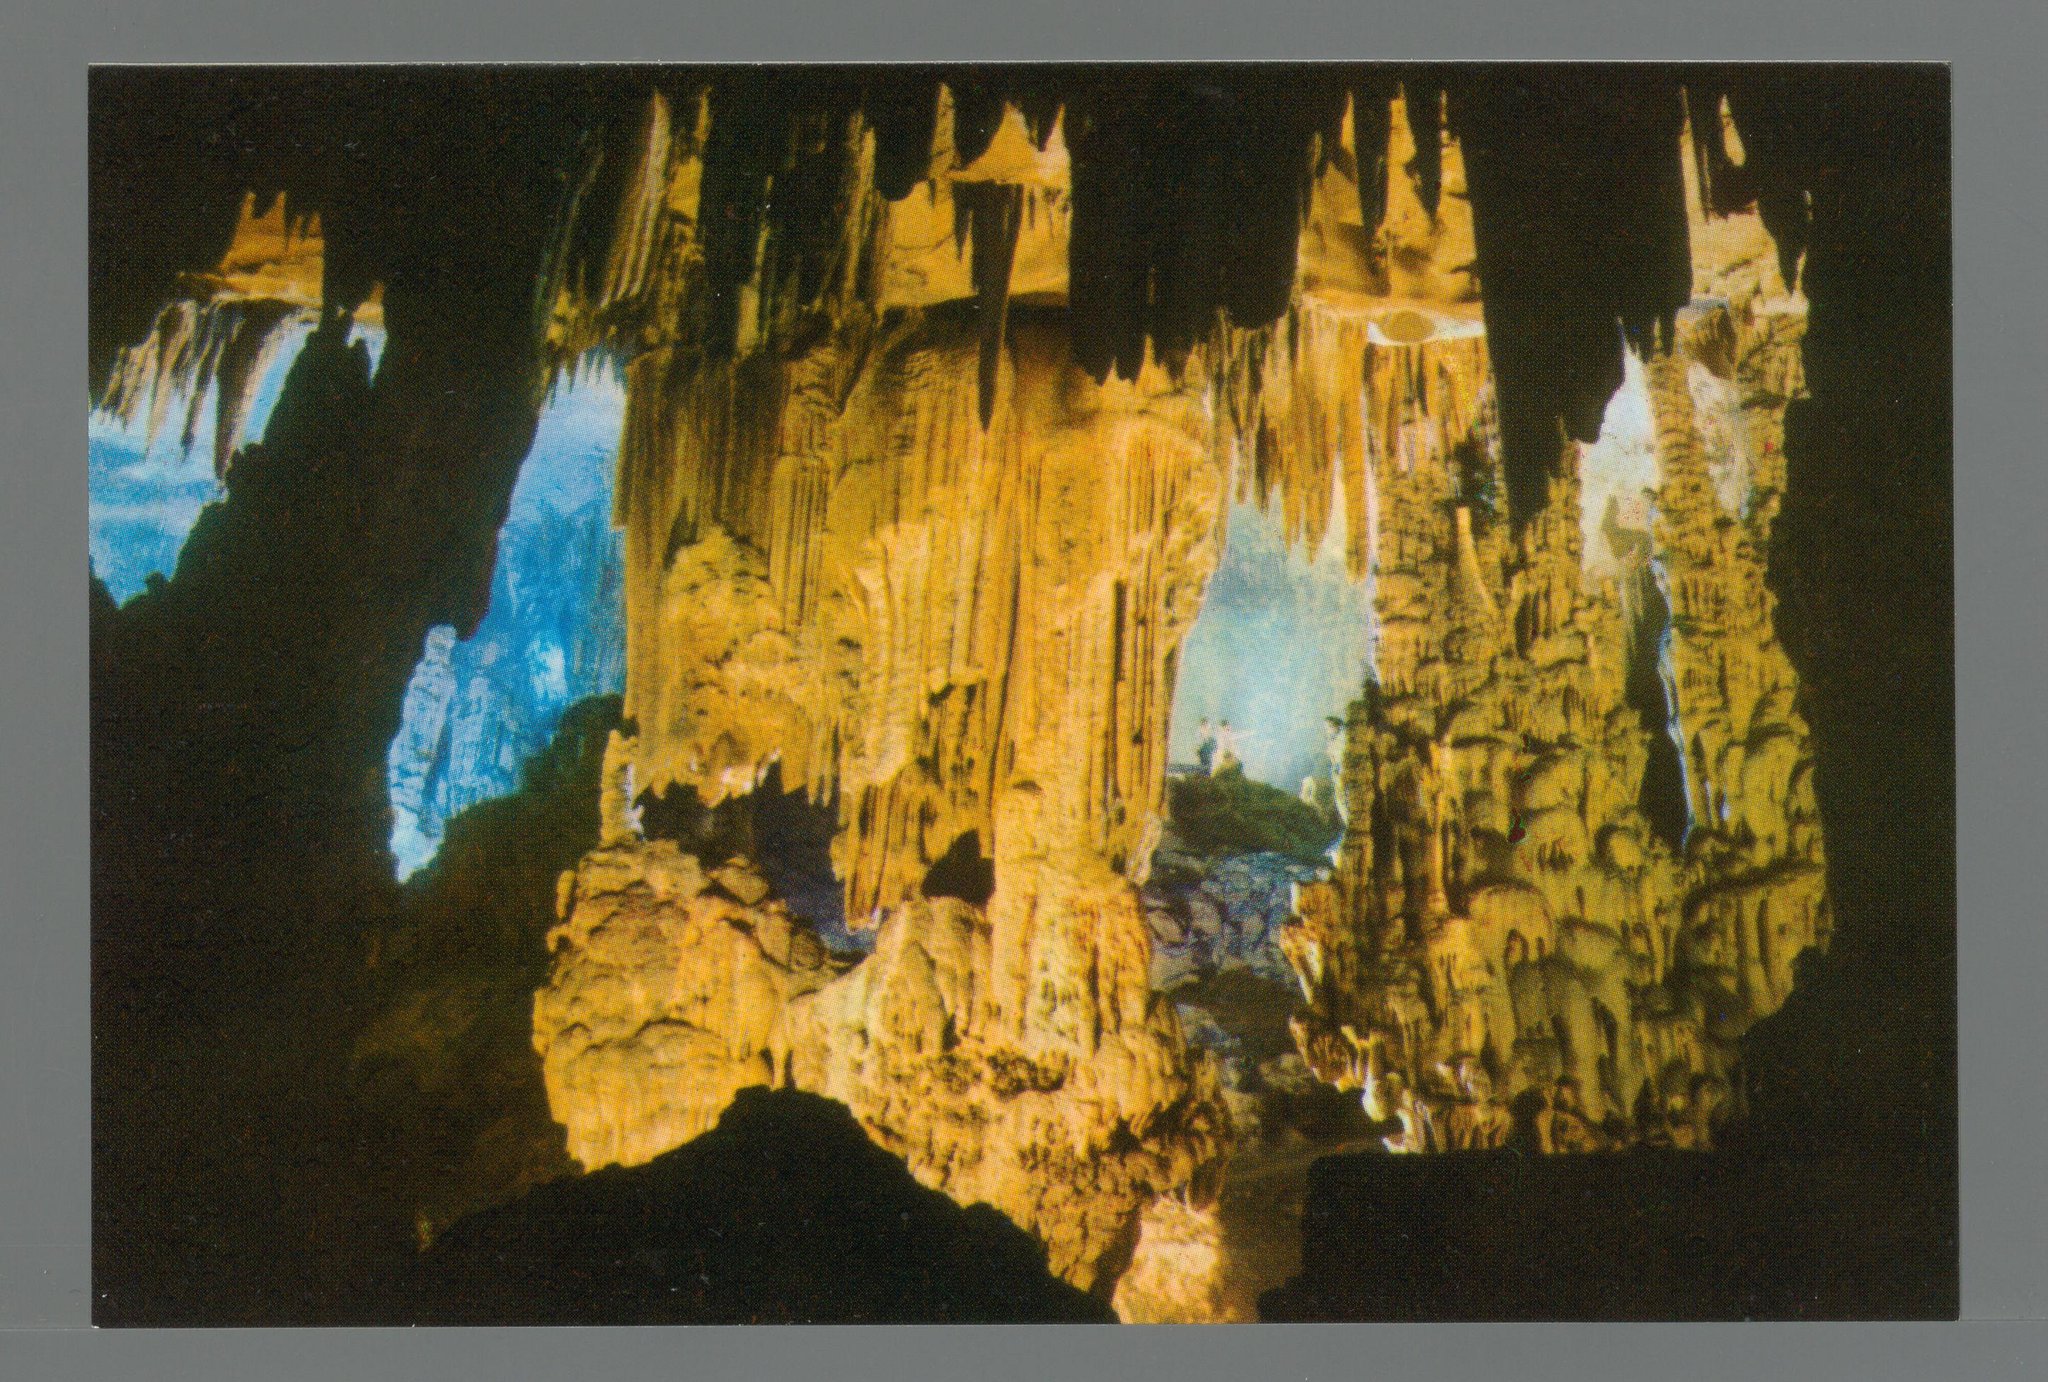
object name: ansichtkaart, prentbriefkaart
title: Dripstones in Reed Flute Cavern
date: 1974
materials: cardboard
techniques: offset printed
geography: china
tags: stalactitic cave